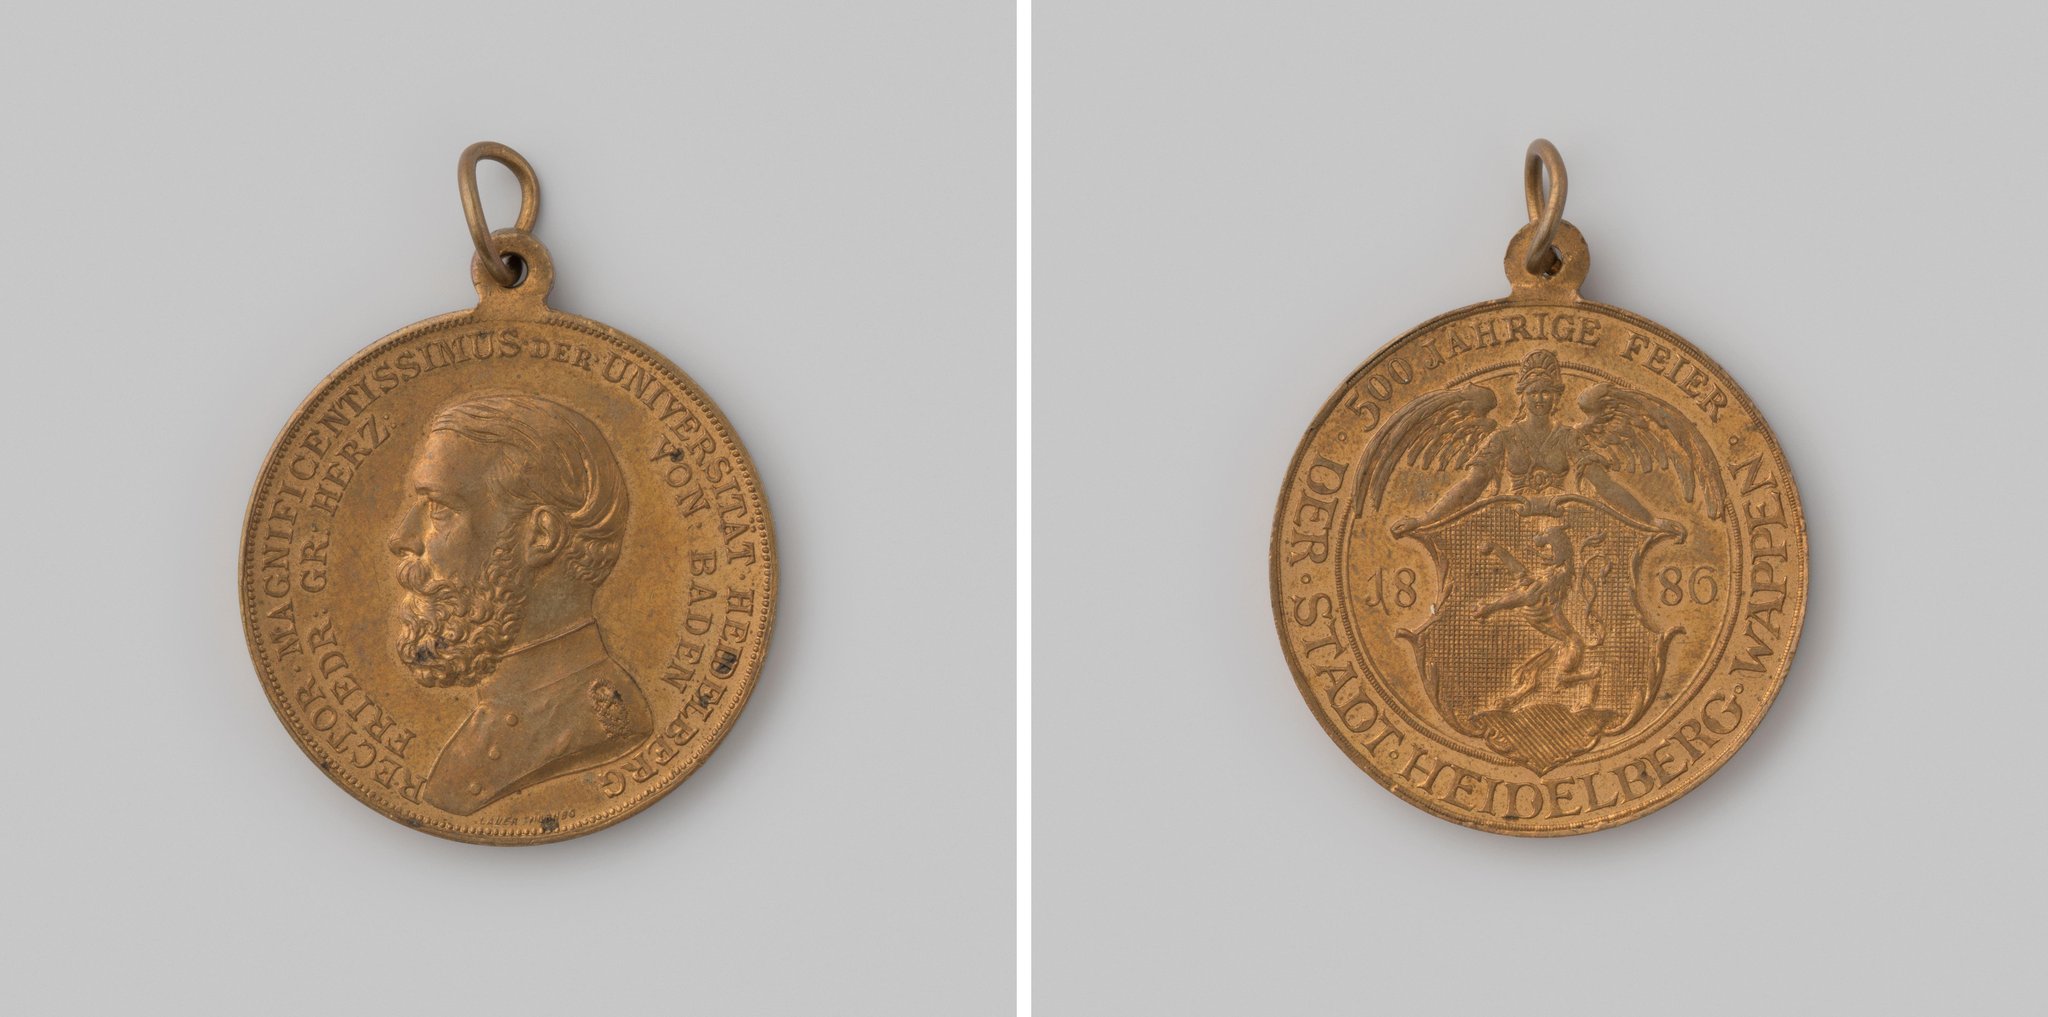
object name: history medal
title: Vijfhonderdjarig bestaan van de Universiteit van Heidelberg 1886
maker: wolfgang lauer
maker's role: medailleur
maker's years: 1856-1915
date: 1886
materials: brass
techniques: striking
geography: nuremberg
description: Messing penning met oog en draagring, op de voorzijde het borstbeeld van Groothertog Frederik van Baden naar links met dubbel omschrift, op de keerzijde het wapenschild van Heidelberg gedragen door Victoria, het jaartal in het veld, met omschrift.